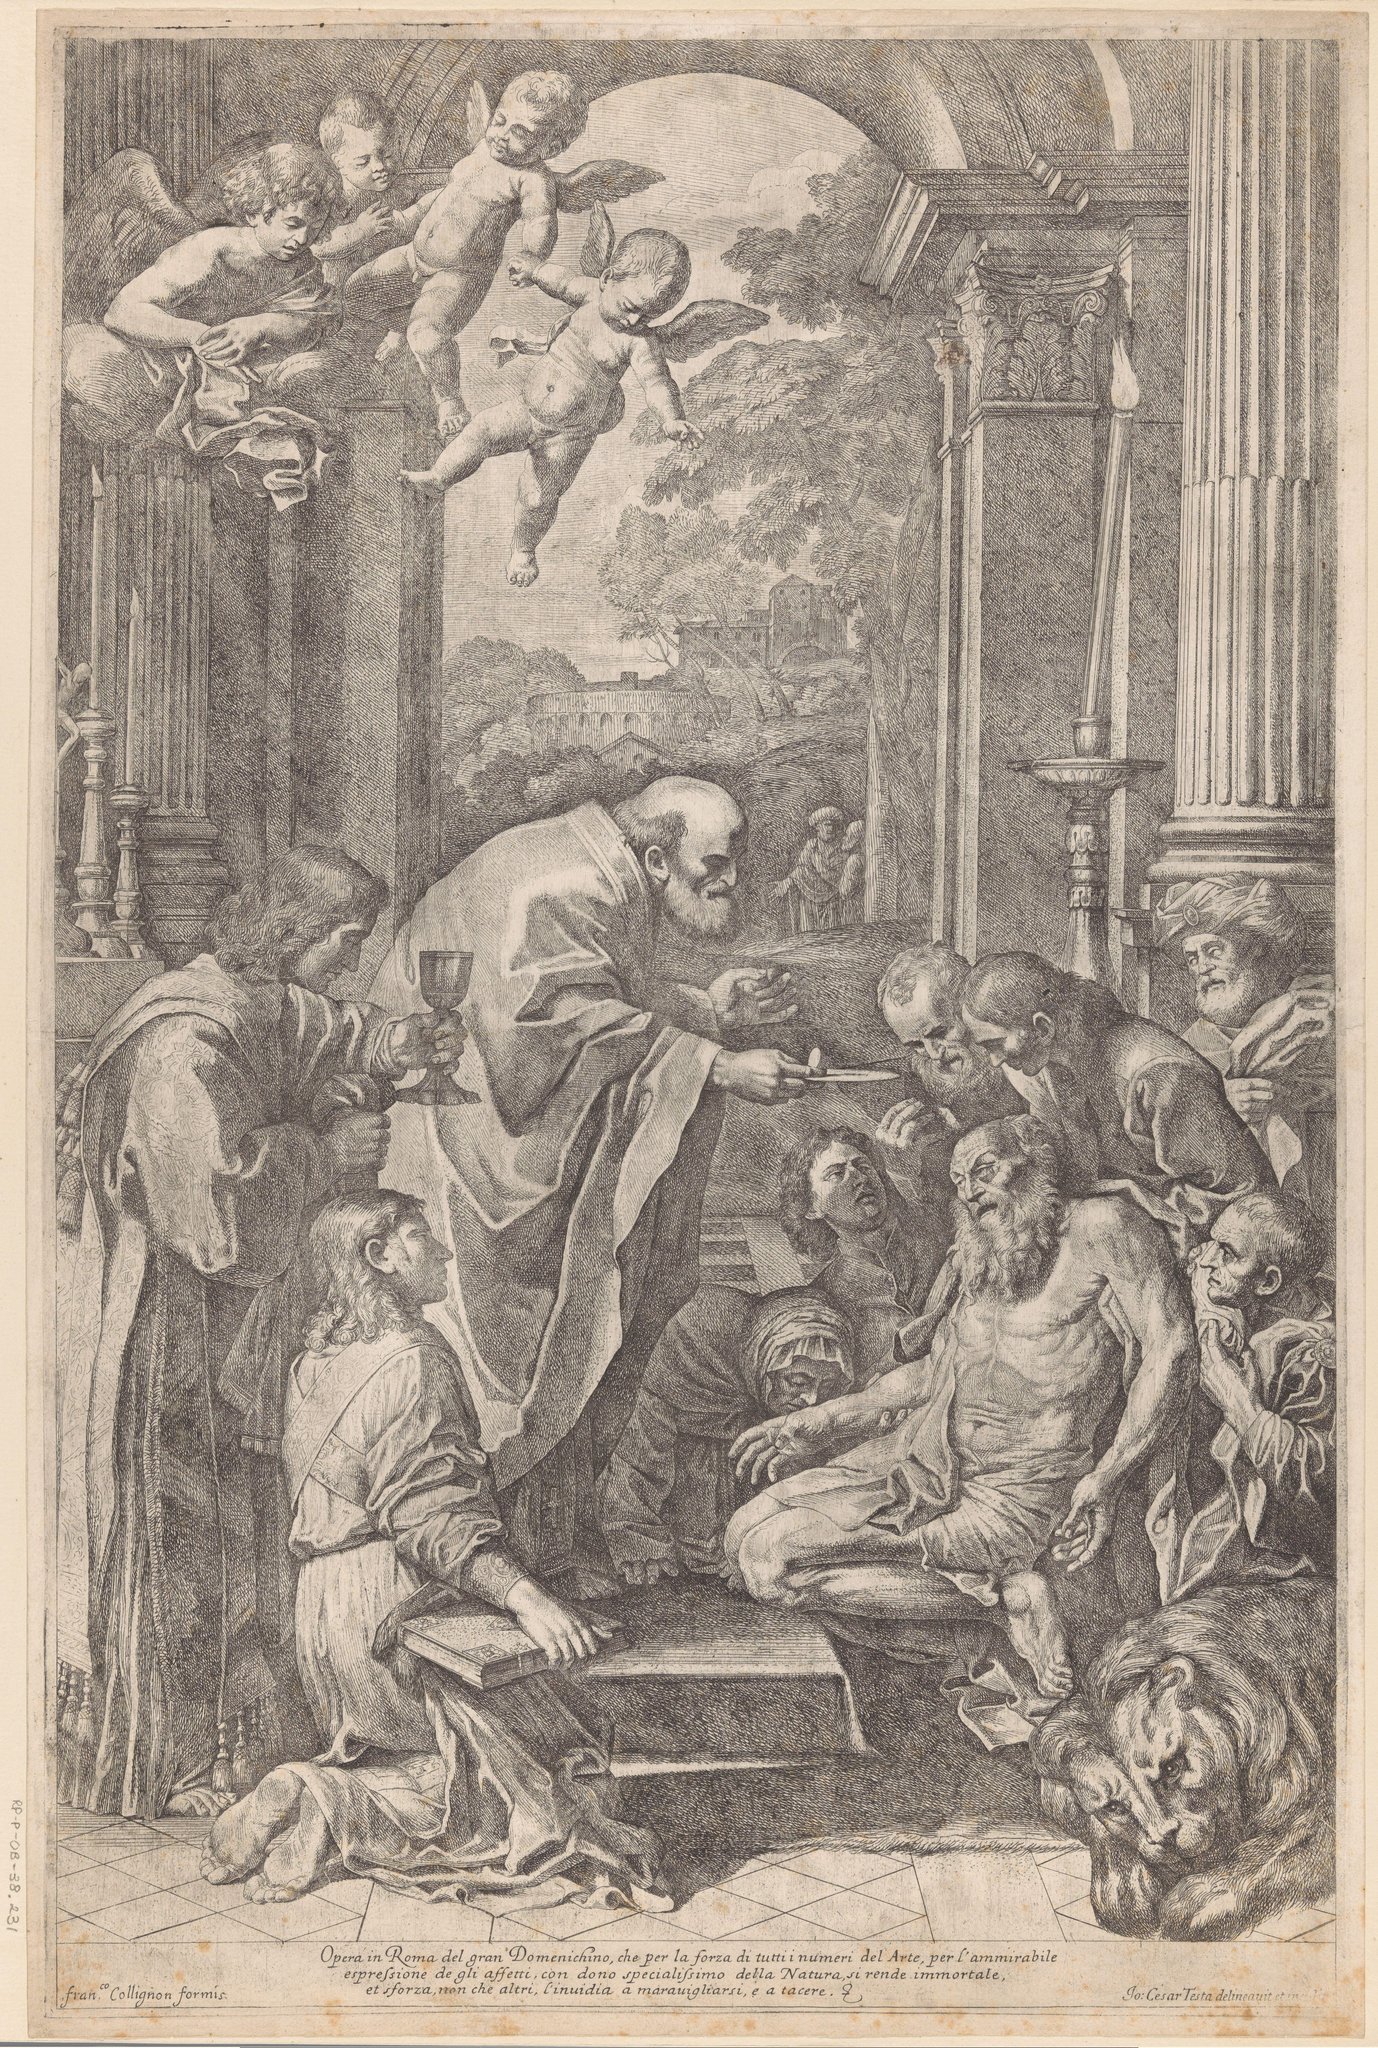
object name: print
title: De laatste communie van de heilige Hieronymus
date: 1637-1691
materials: paper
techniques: etching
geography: italy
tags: extreme unction ~ the last of the seven sacraments, the monk and hermit jerome (hieronymus); possible attributes: book, cardinal's hat, crucifix, hour-glass, lion, skull, stone, cupids: 'amores', 'amoretti', 'putti'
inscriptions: collector's mark: Lugt 240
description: Gezicht in een kerk waar de heilige Hieronymus de laatste teerspijze krijgt van een priester. Hieronymus wordt omringt door mensen die hem steunen. Bij zijn voeten ligt de leeuw. Boven zweven putti. Onderschrift in het Italiaans.